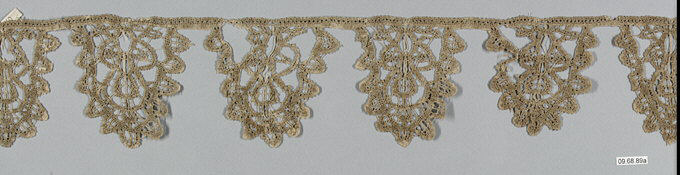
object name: edging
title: Edging of bobbin lace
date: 1601-1633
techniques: lace